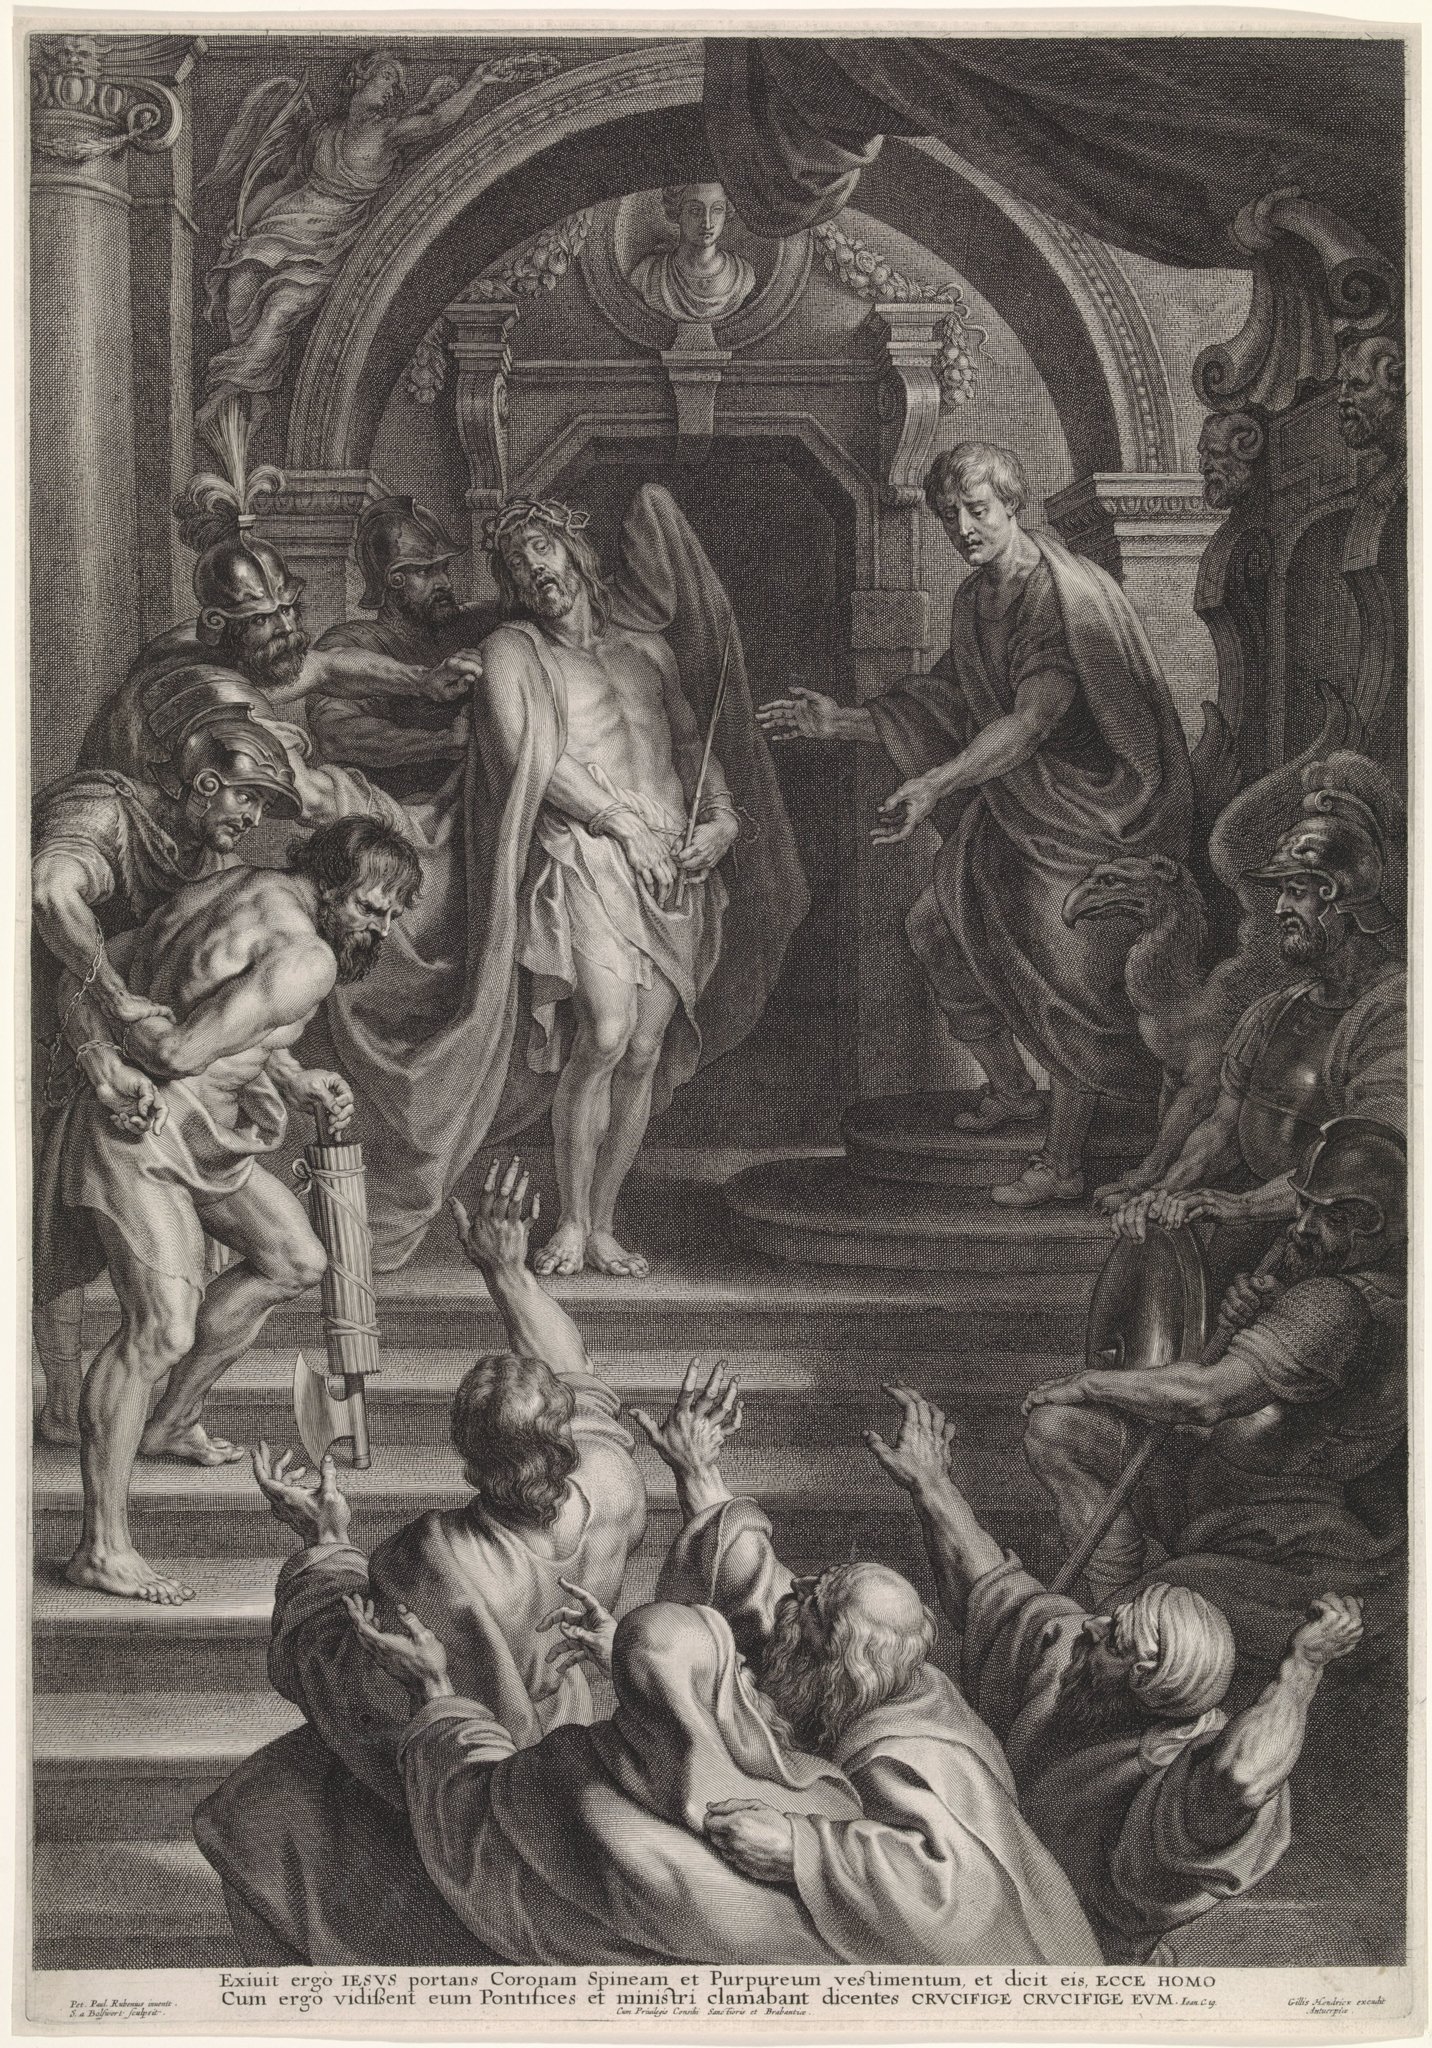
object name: print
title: Pontius Pilatus toont Christus aan de joden voor het gerechtsgebouw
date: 1596-1659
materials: paper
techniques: engraving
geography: antwerp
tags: pilate showing christ to the people, 'ostentatio christi', 'ecce homo' (john 19:4-6)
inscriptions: collector's mark: Lugt 240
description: Pontius Pilatus toont Christus aan de joden voor het gerechtsgebouw. De hogepriesters schreeuwen om zijn kruisiging af te dwingen. In de marge onder staat een fragment uit bijbeltekst Johannes 19.